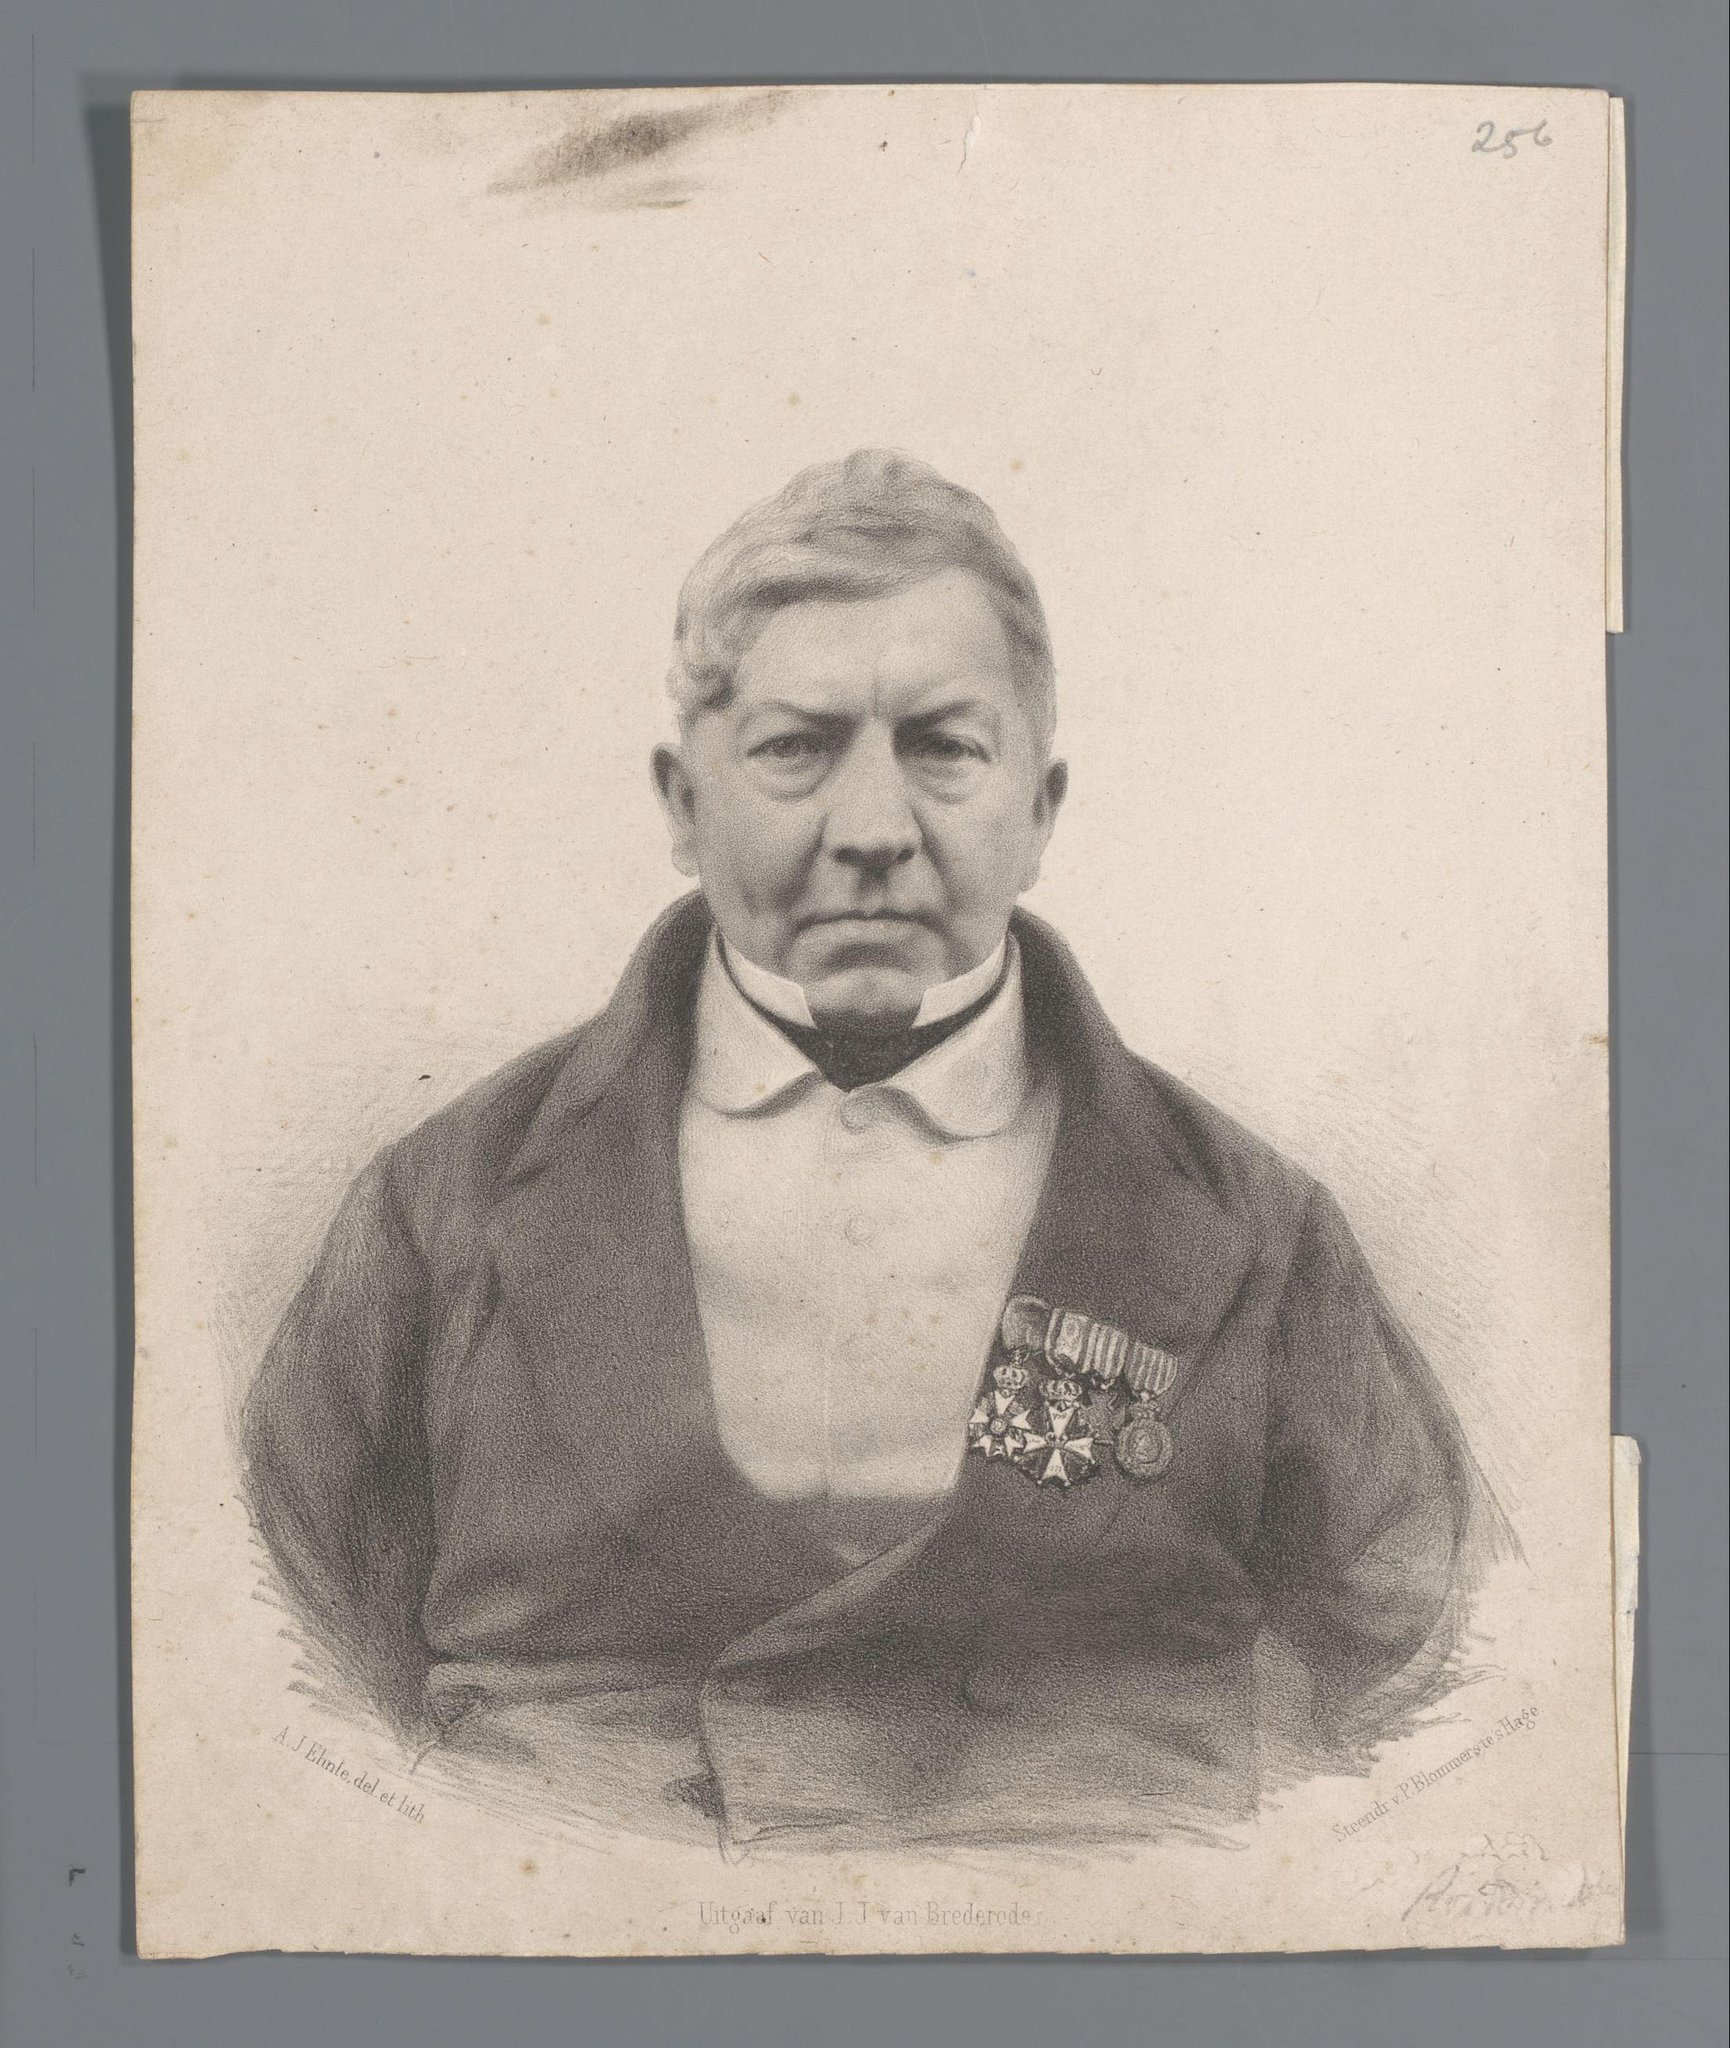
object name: print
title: Hendrik Rookmaker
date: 1847-1883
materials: paper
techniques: lithograph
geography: the hague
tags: arnhem, haarlem, historical persons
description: Portret van Hendrik Rookmaker, commandant der Vrijwillige Noord Hollandse jagers. Half-figuur, frontaal, met links op de borst vier eretekens.